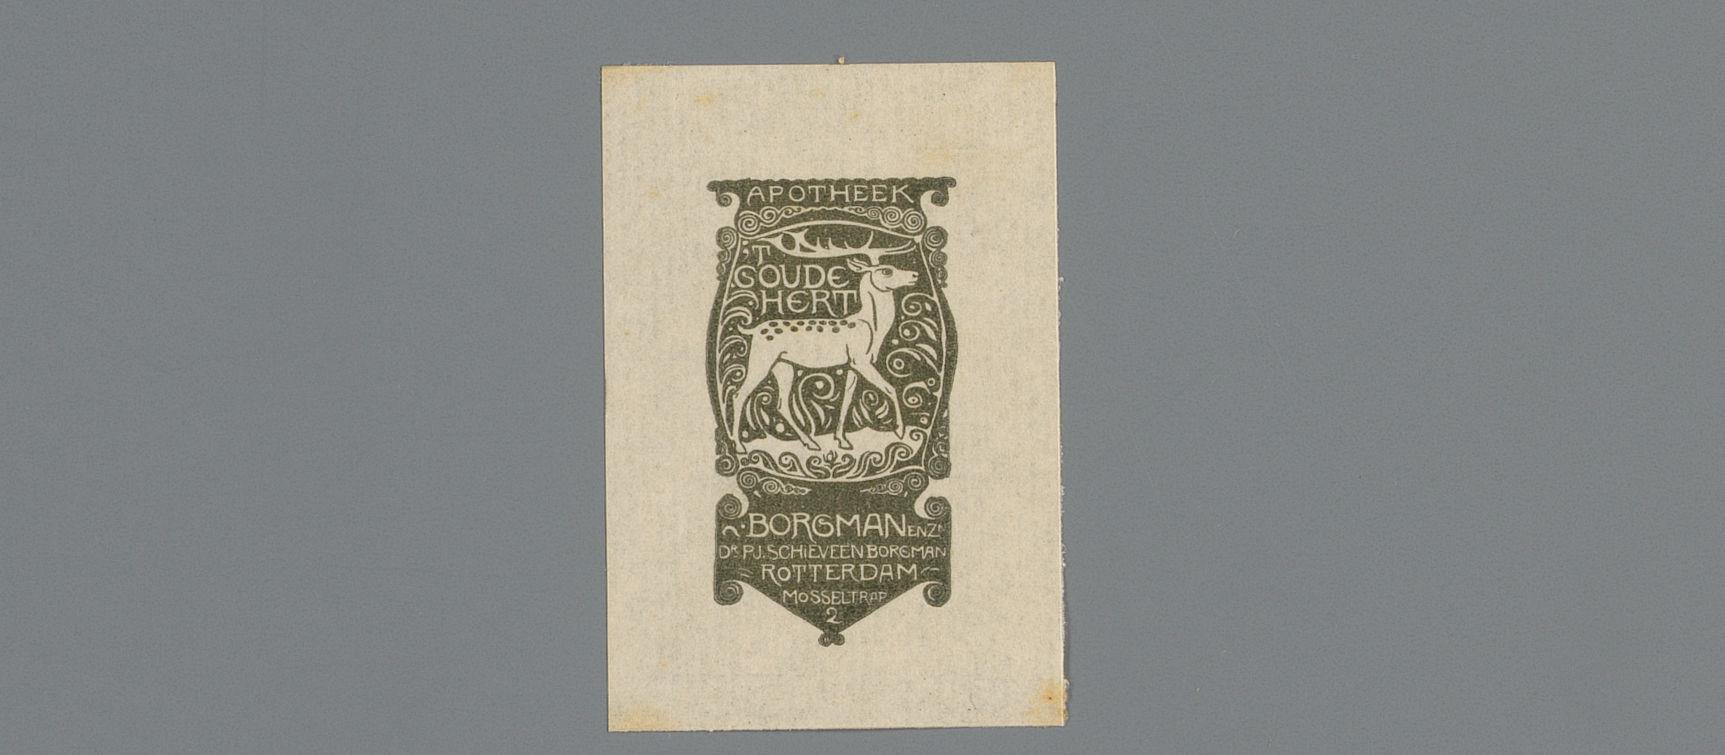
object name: vignette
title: Sluitzegel met vignet van Apotheek 't Goude Hert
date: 1910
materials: gum, paper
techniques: printing block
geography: netherlands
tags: hoofed animals: deer, trade mark, trade token, trade sign, trade card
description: Sluitzegel met vignet van Apotheek 't Goude Hert van Borgman en Zn en Dr P.J. Schieveen Borgman te Rotterdam, 1910.